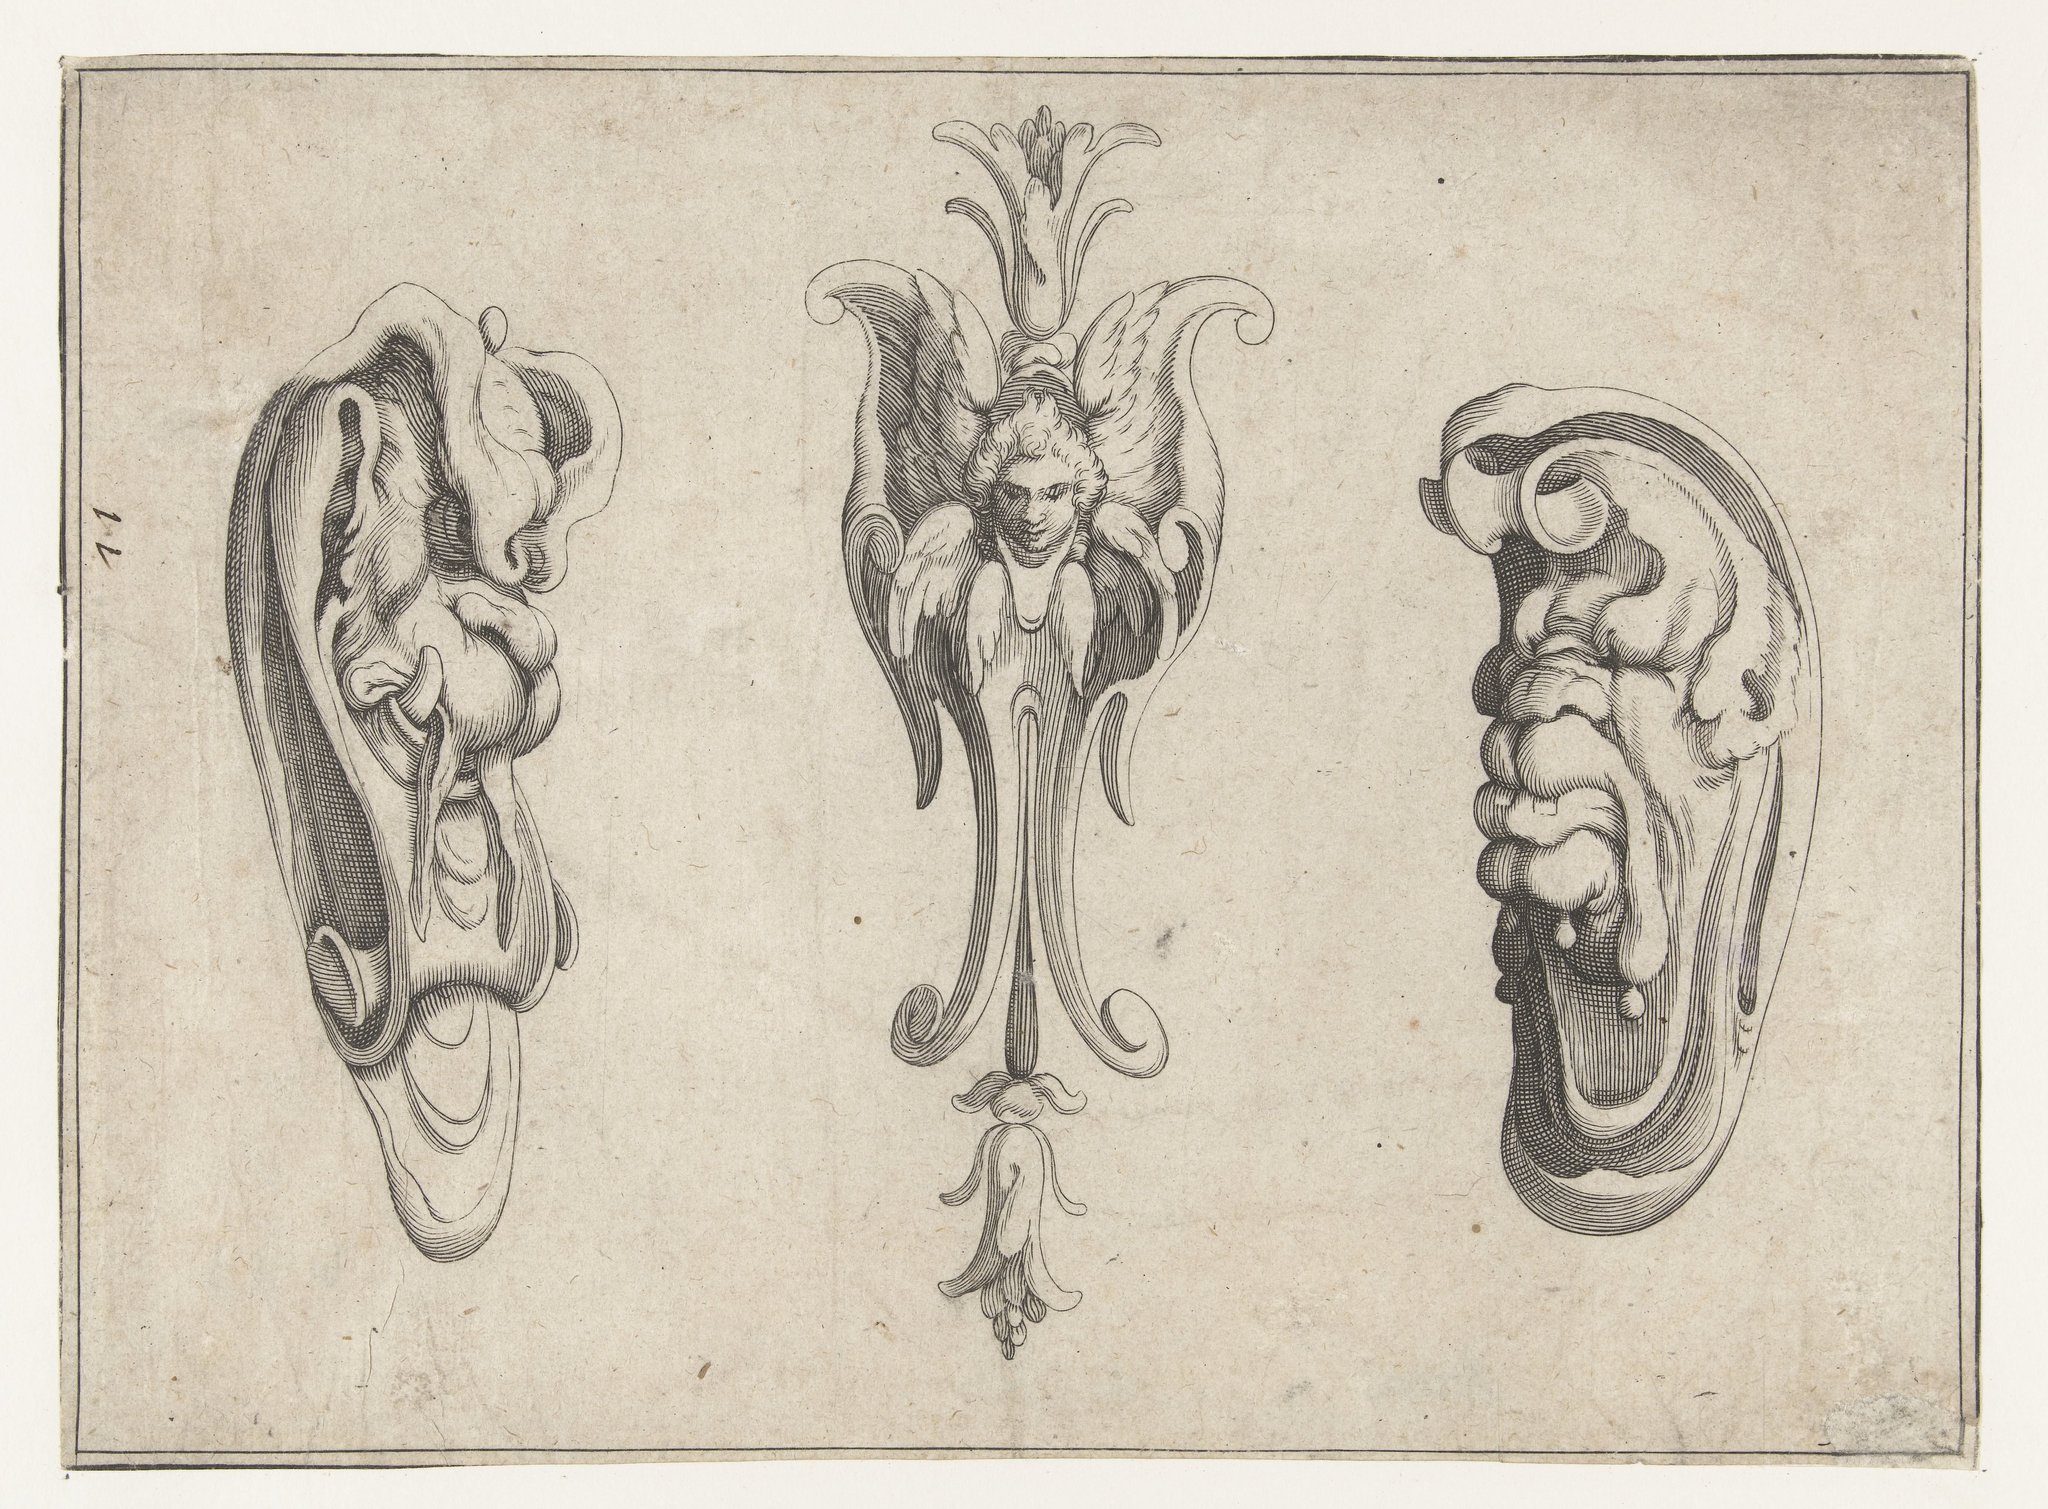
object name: print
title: Ornament met een cherubijn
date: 1604-1616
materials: paper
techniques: engraving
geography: paris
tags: cherubs, i.e. children's heads with wings, mask, mascaron ~ ornament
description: de serie bestaat uit 7 prenten ipv 6 (Orn Cat I). Zie: 'Comments on catalogue entries' by P. Fuhring, in: Print Quarterly VI, (1989), p. 327